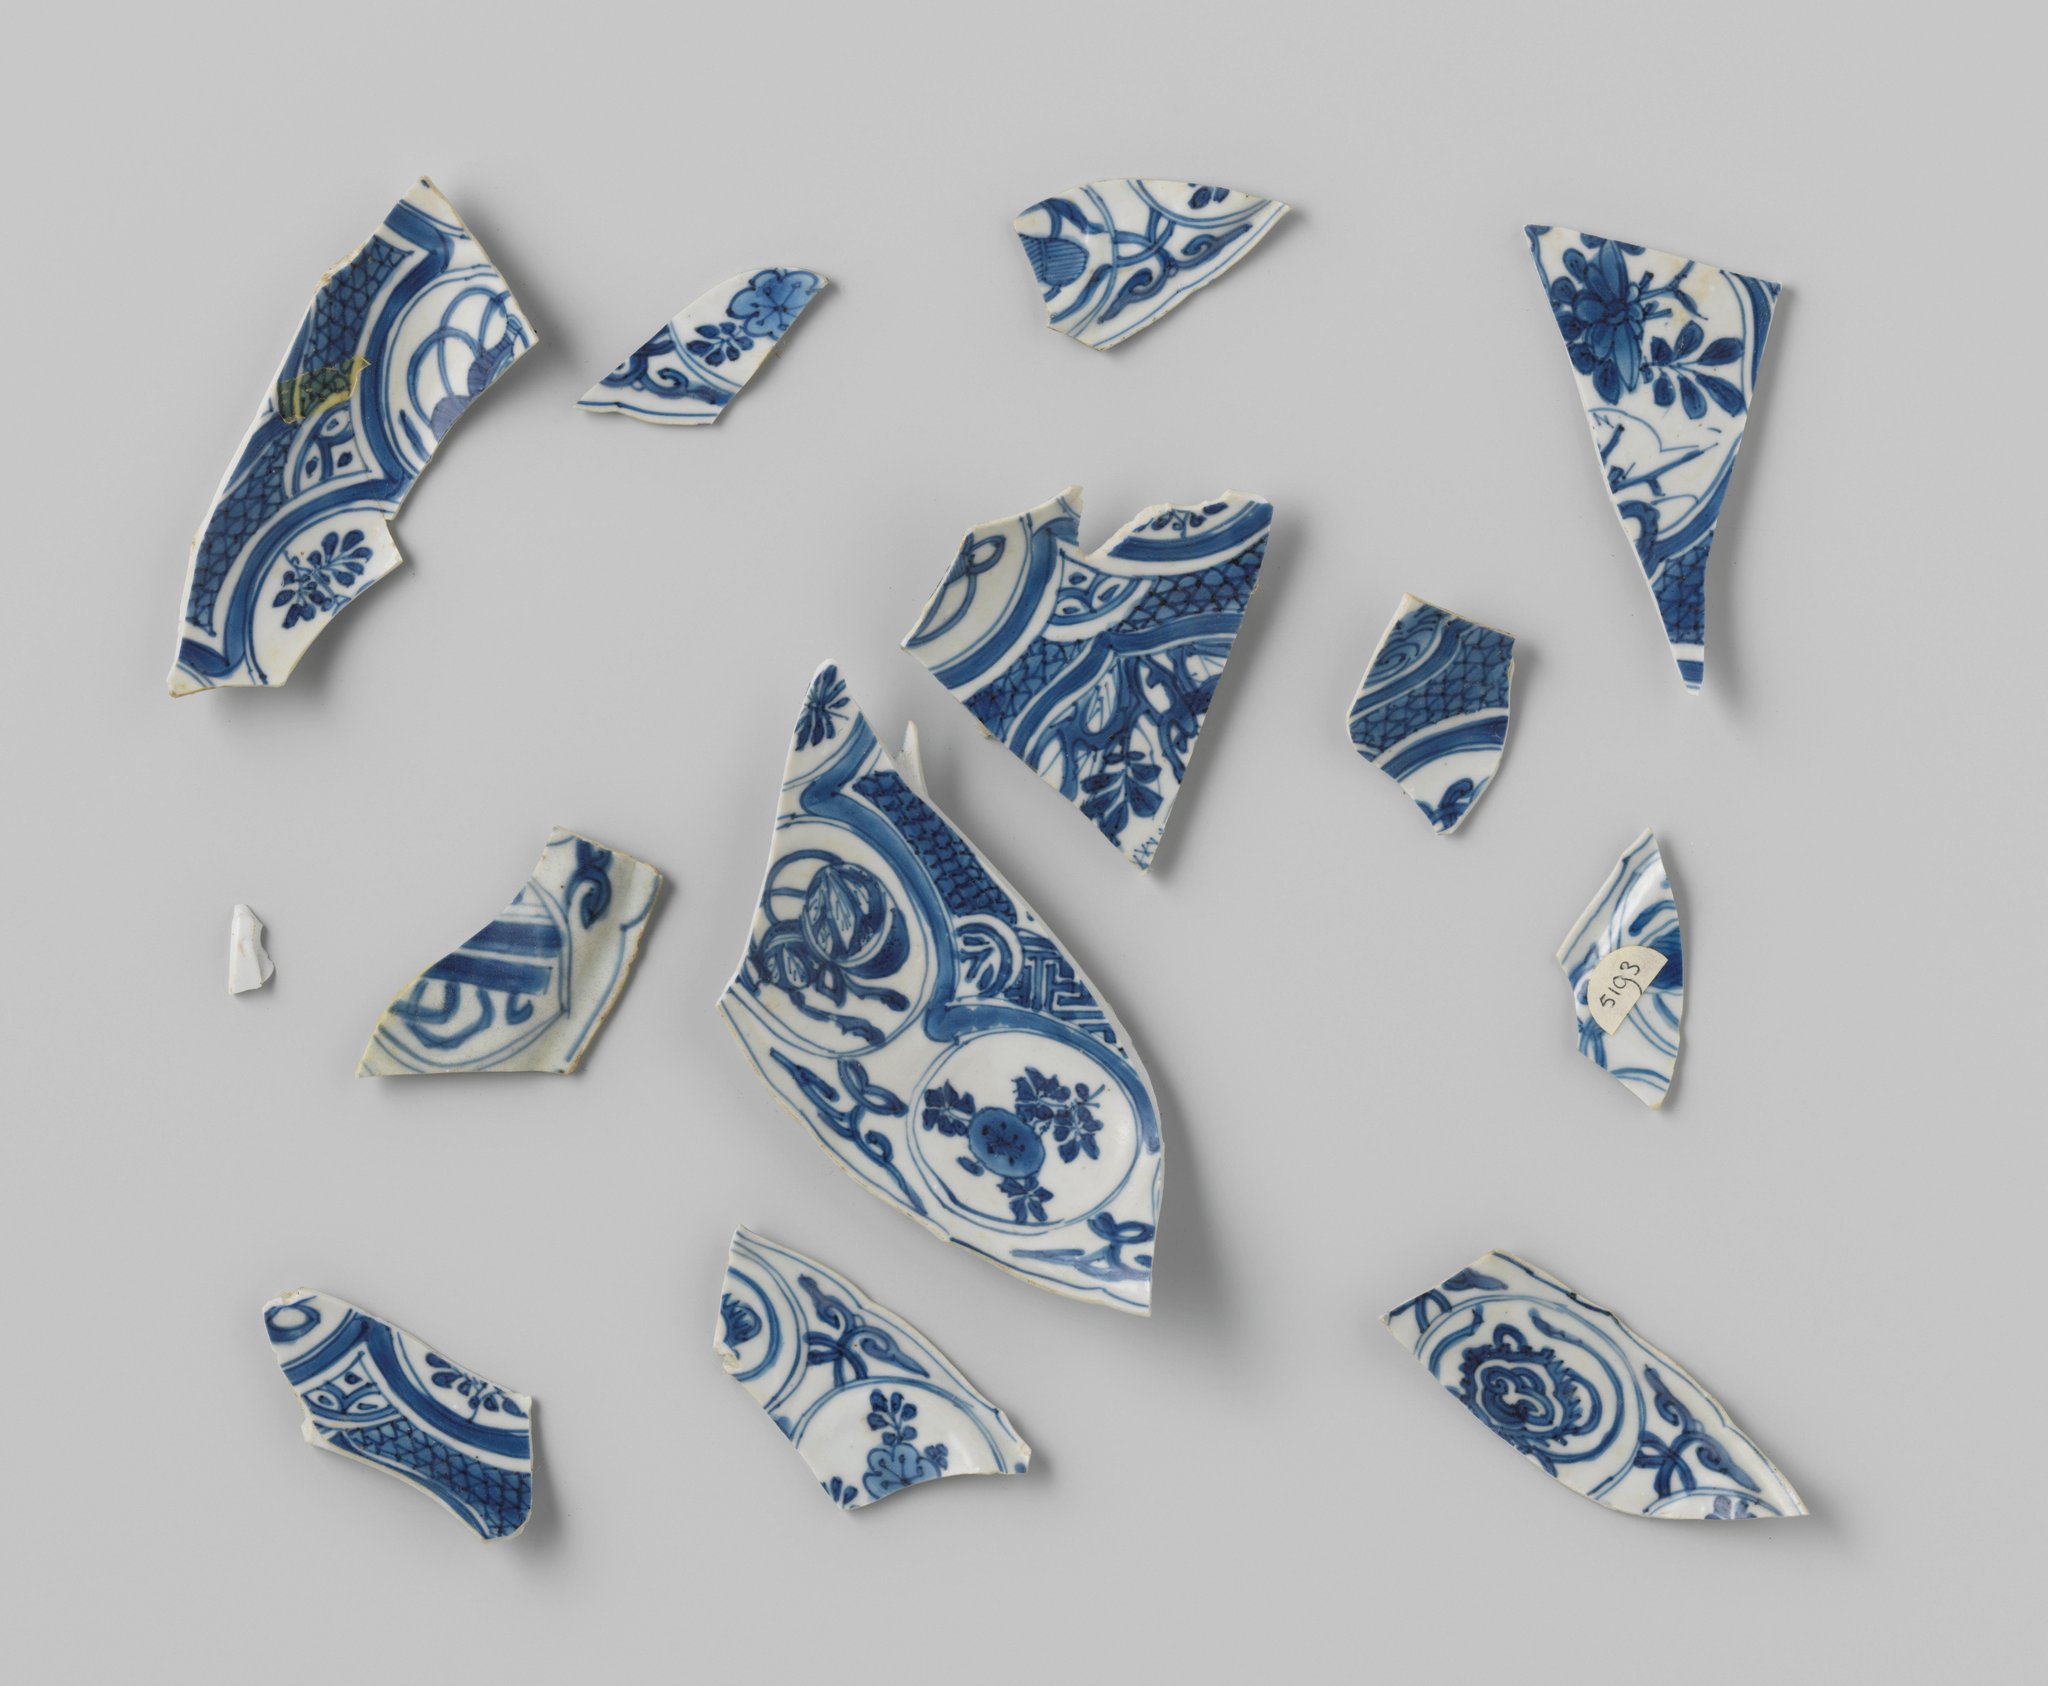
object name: plate dish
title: Scherven van borden uit V.O.C.-schip de 'Witte Leeuw'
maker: Anonymous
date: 1613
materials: bone china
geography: jingdezhen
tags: verenigde oostindische compagnie, sint-helena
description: A dish without a flattened rim. A scalloped medallion with 5 rui heads within a star-shaped medallion filled with various diaper patterns. A central decoration of one flying bird and a bird on a rock under a lotus plant. The medallions decorated with alternately a peach or crabapple and a symbol.